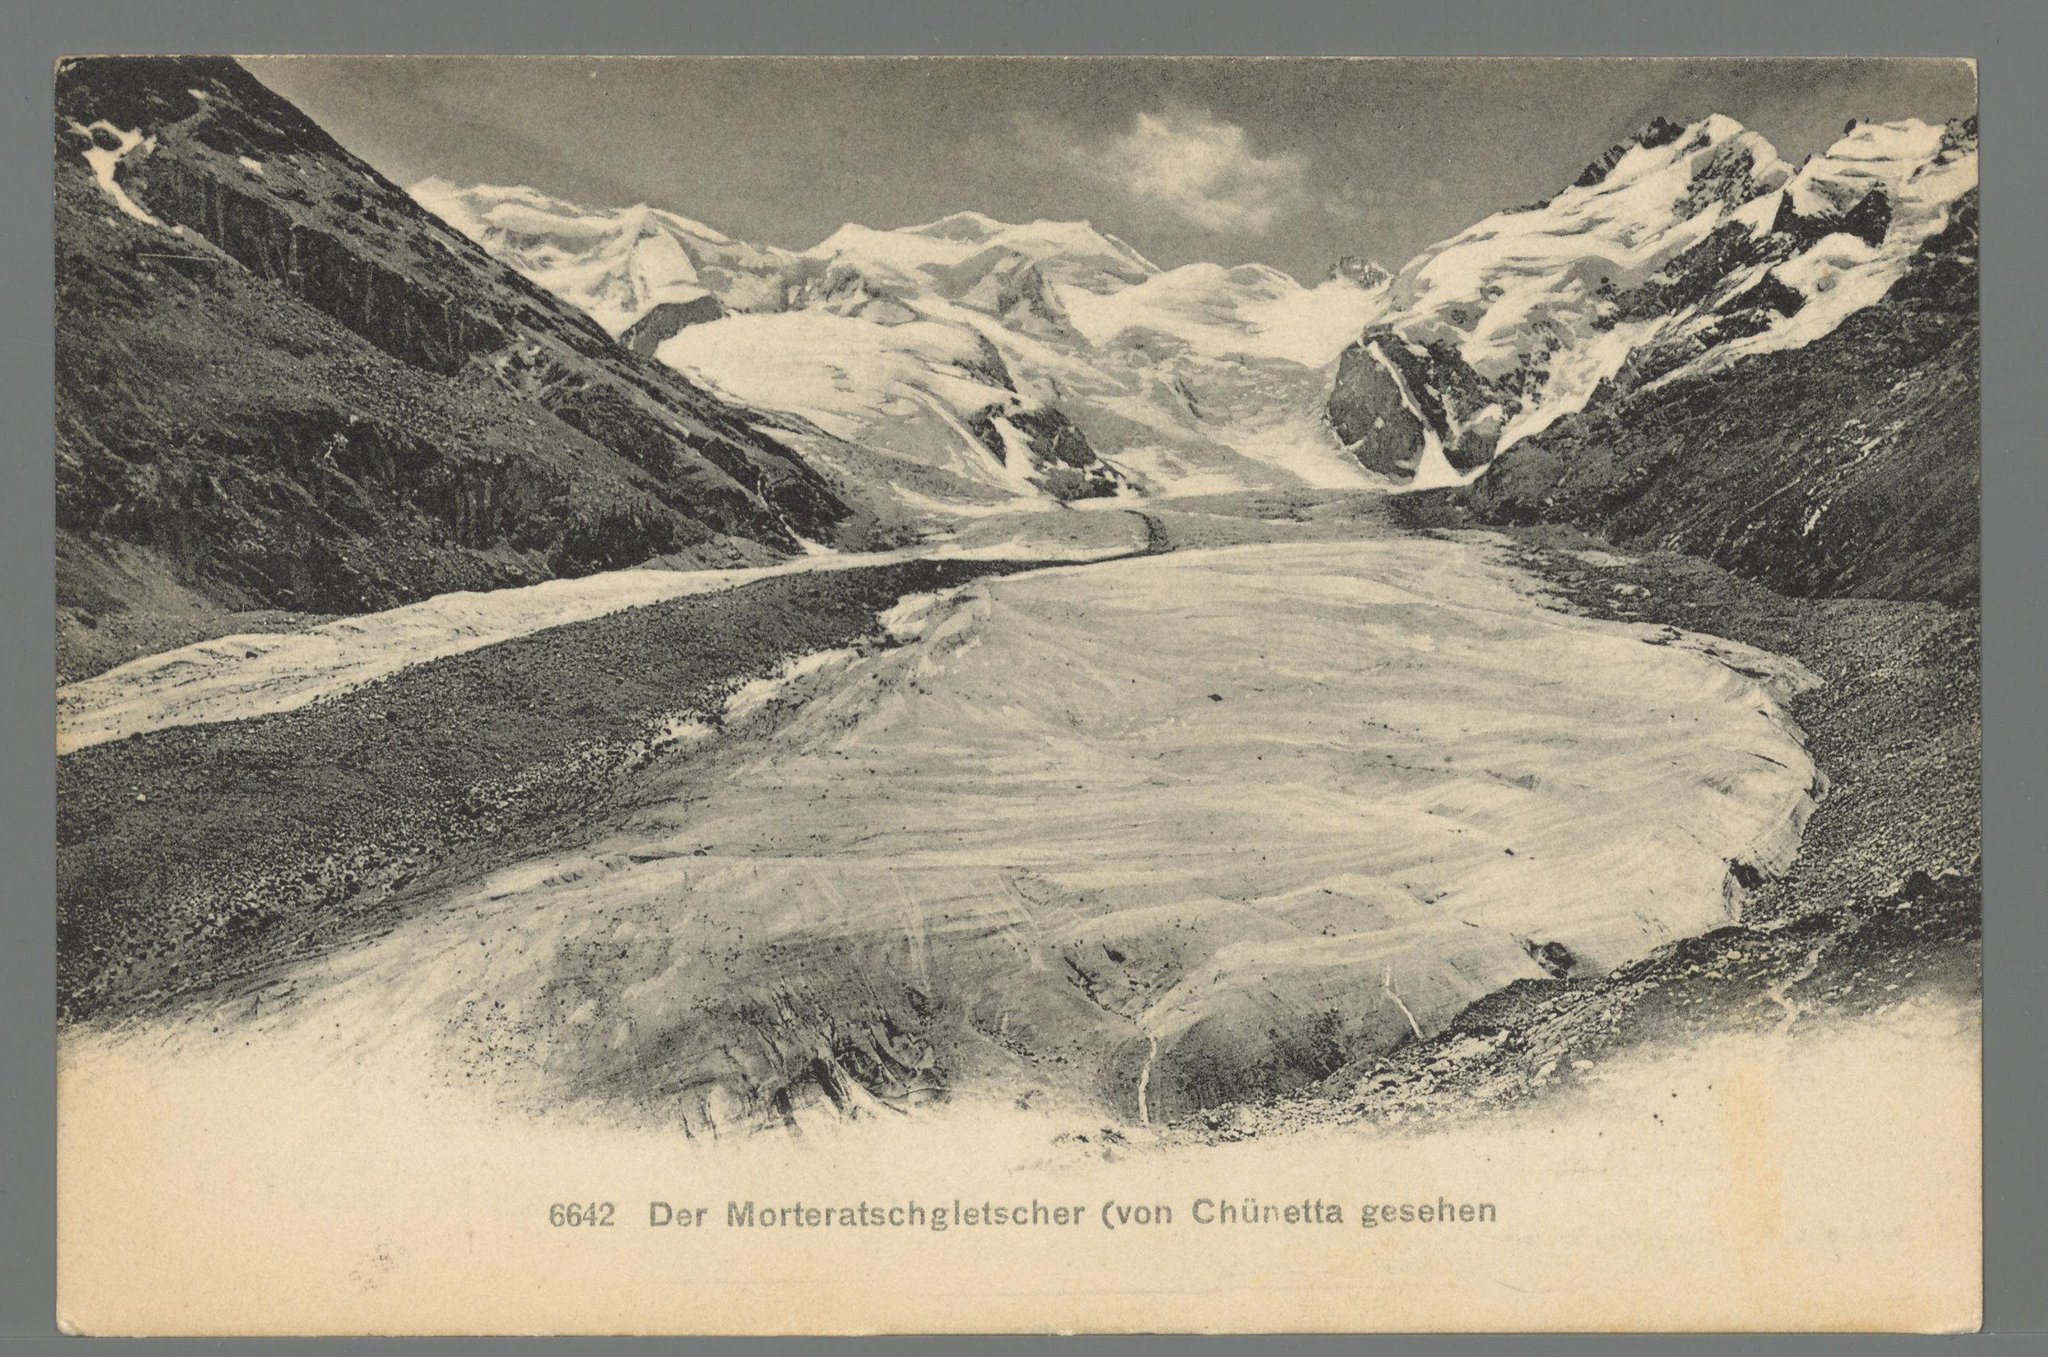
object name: photomechanical print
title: Der Morteratschgletscher (von Chünetta gesehen)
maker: Anonymous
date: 1905-1910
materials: cardboard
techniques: photograph, writing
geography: morteratschgletsjer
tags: glacier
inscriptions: postage stamp